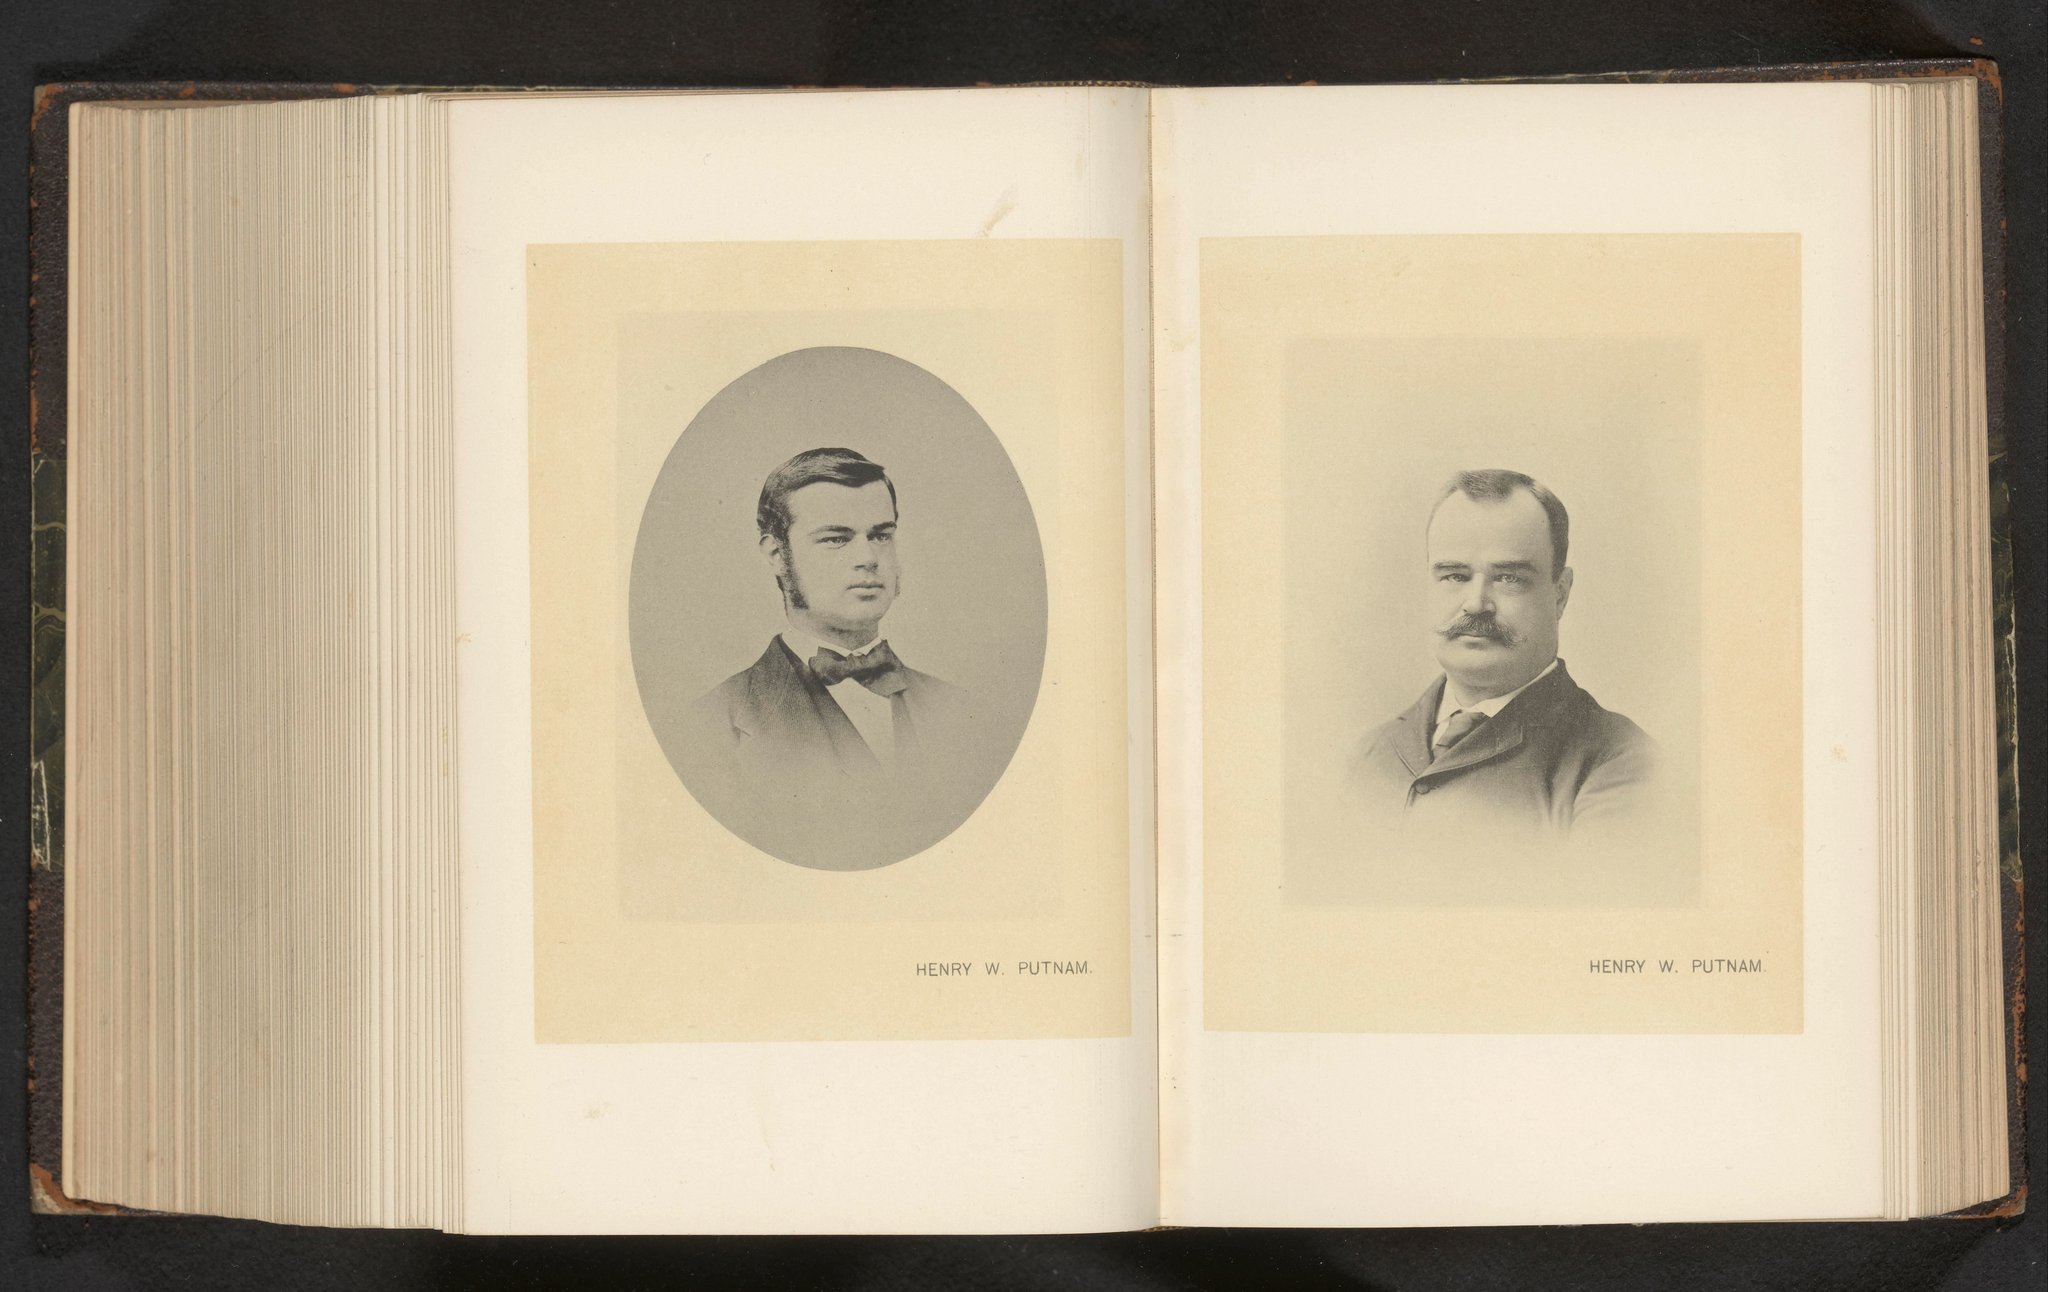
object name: photomechanical print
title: Henry W. Putnam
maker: Anonymous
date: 1889-1894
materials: paper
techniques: photoaquatint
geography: boston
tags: adult man